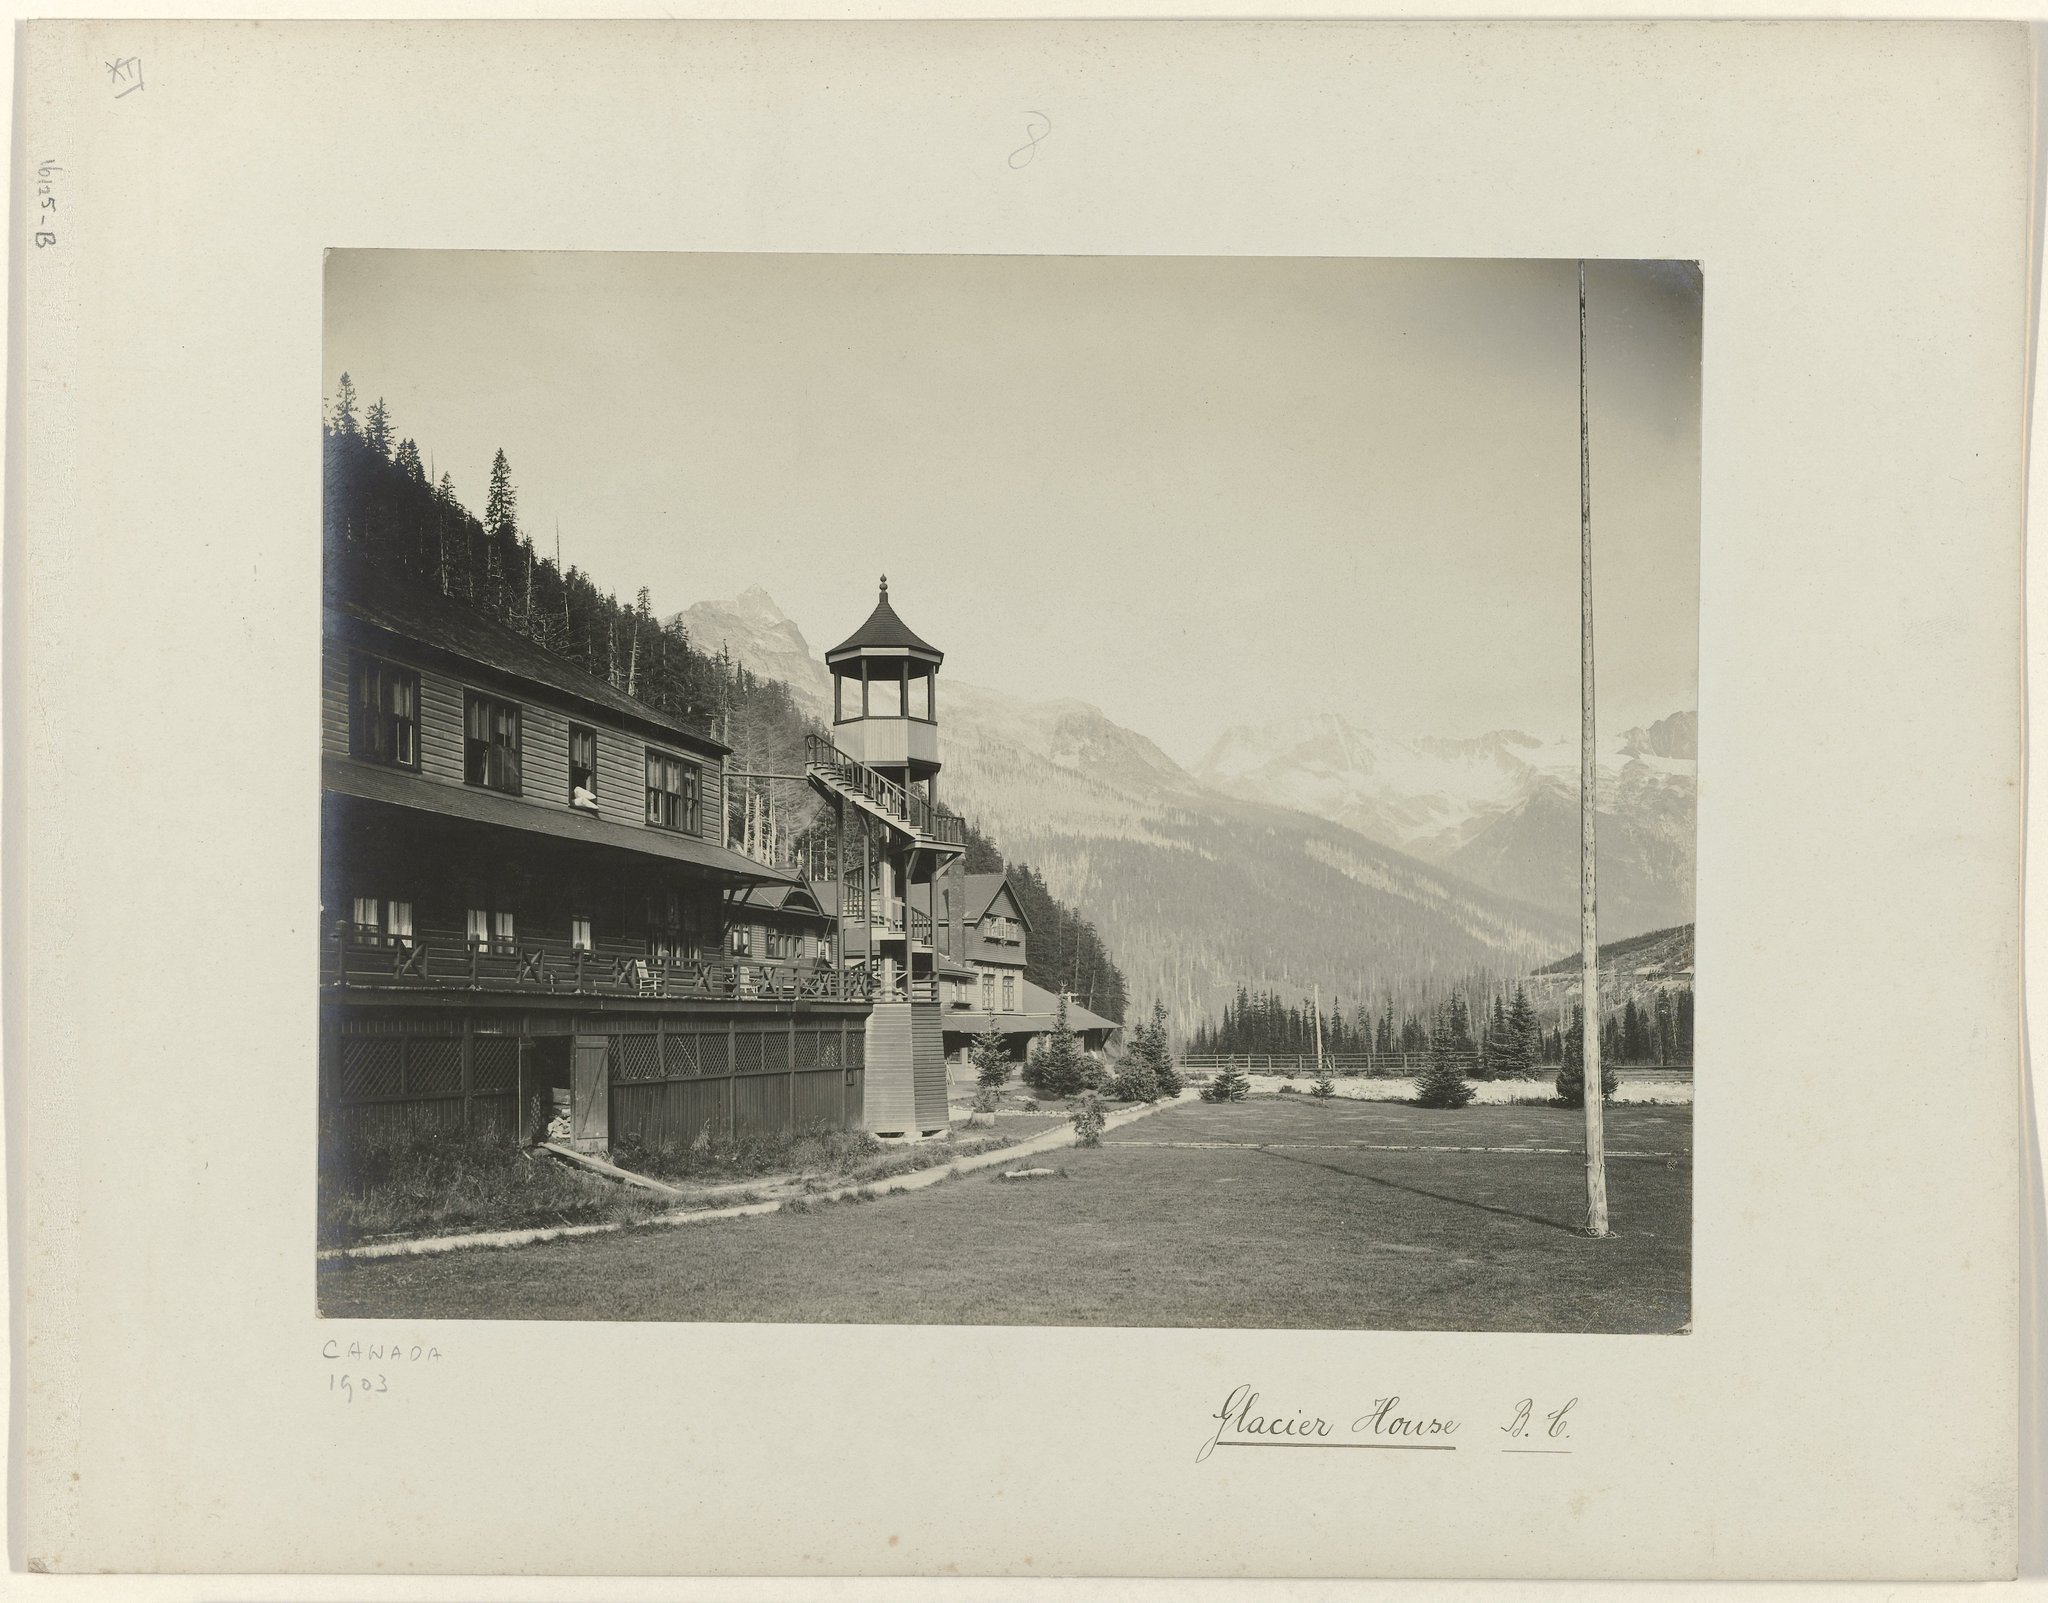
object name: photograph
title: Glacier House, B.C.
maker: william mcfarlane notman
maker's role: fotograaf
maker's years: -1913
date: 1903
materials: paper, cardboard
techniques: gelatin silver print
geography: british columbia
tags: mountains